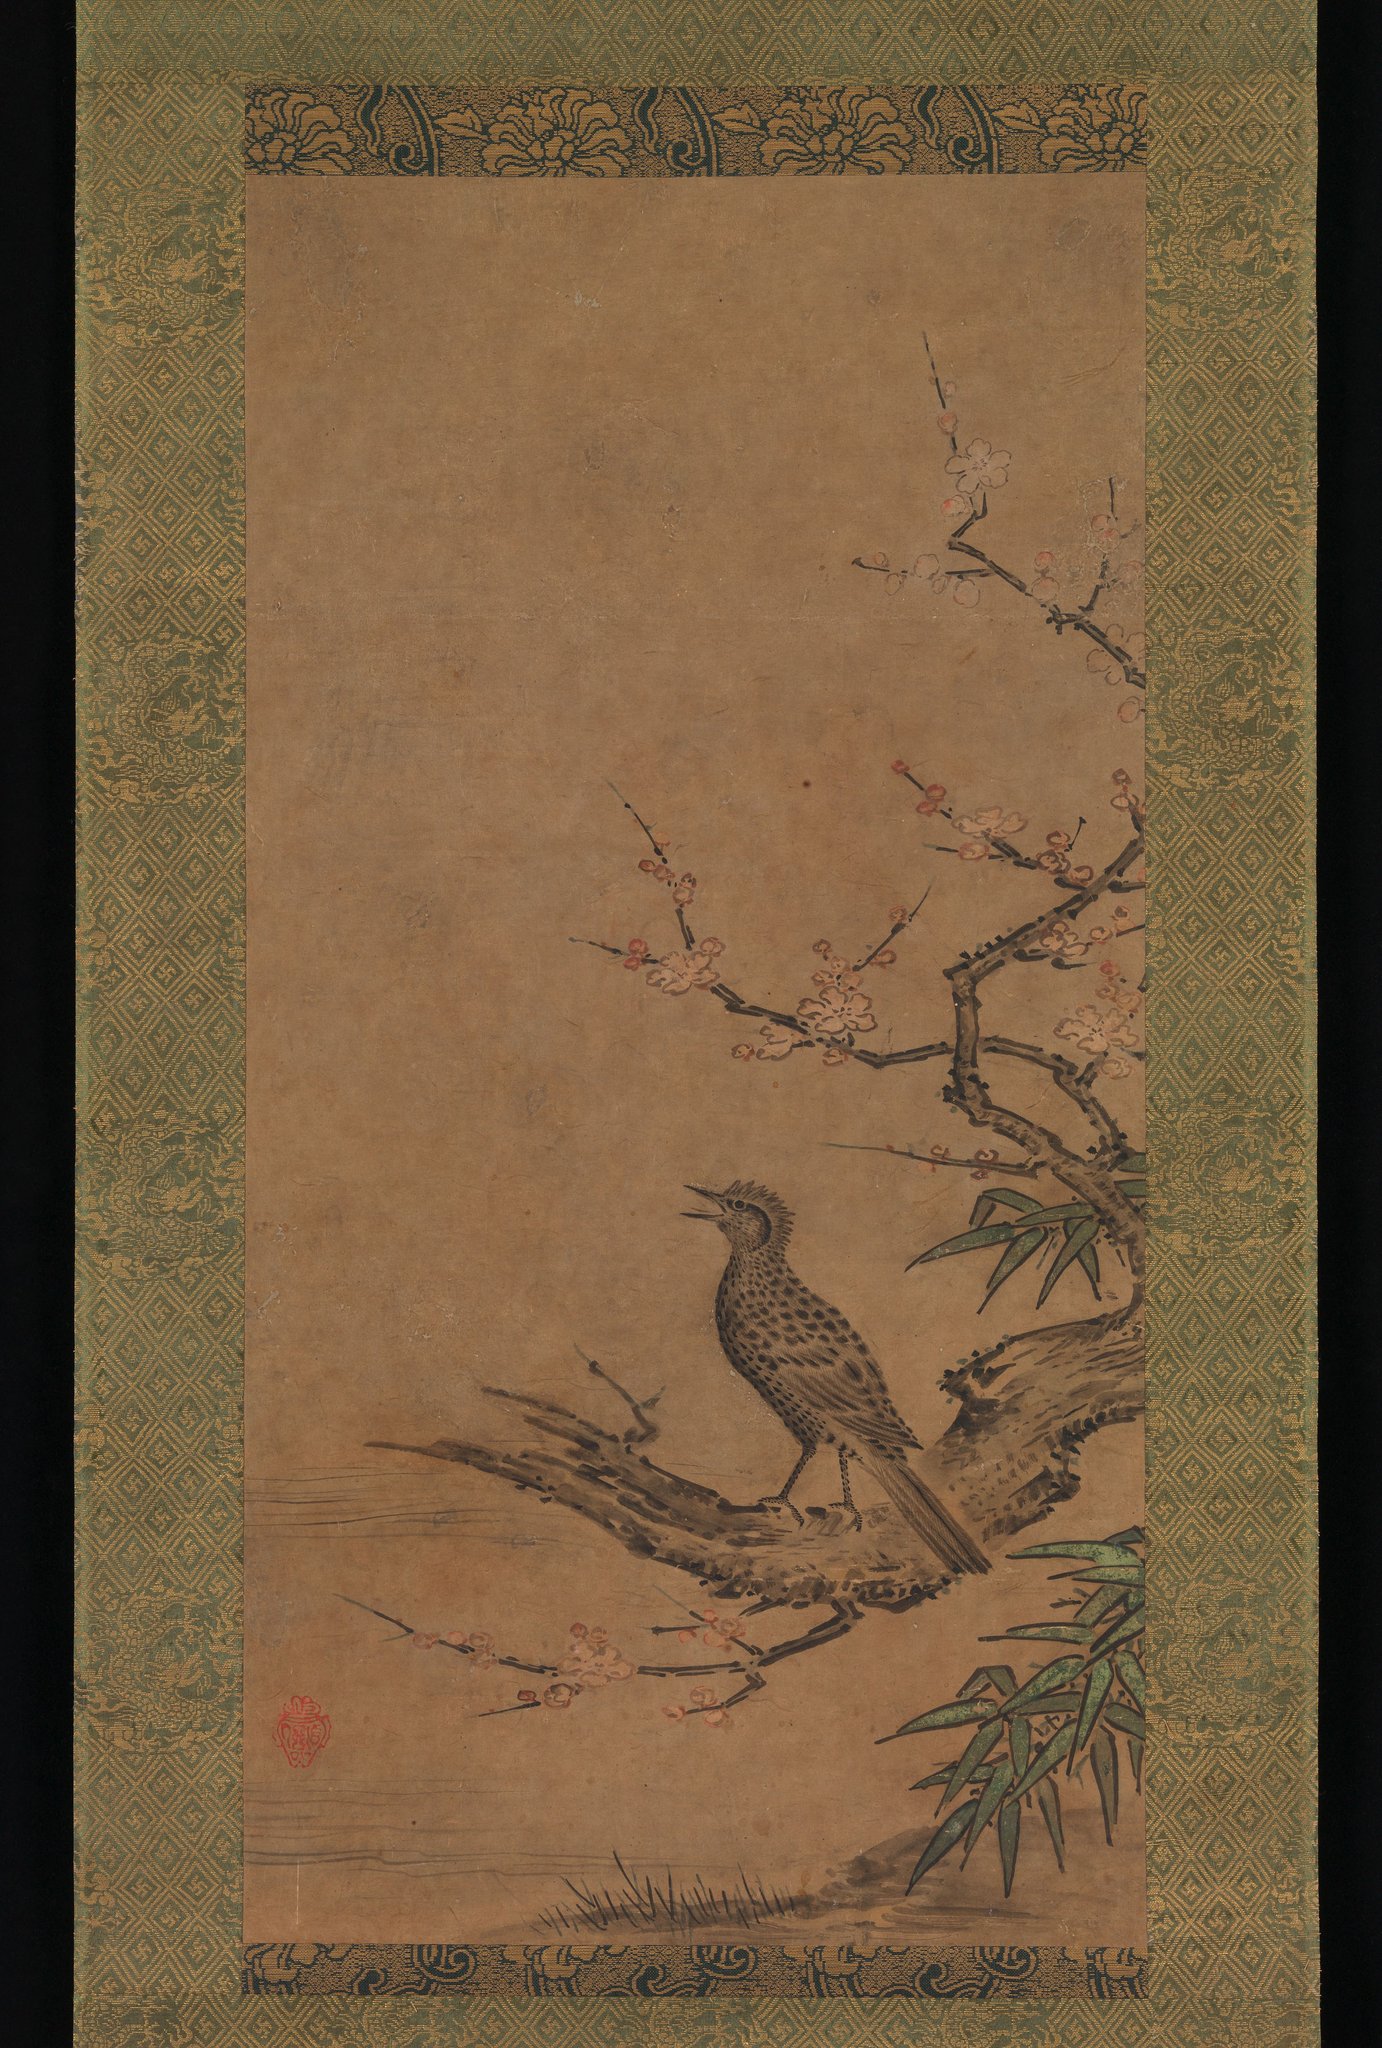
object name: hanging scroll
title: Brown-Eared Bulbul (Hiyodori) on a Branch of Plum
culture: japanese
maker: kano shōei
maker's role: artist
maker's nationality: japanese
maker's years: 1519-1592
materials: ink, paper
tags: birds,flowers,trees